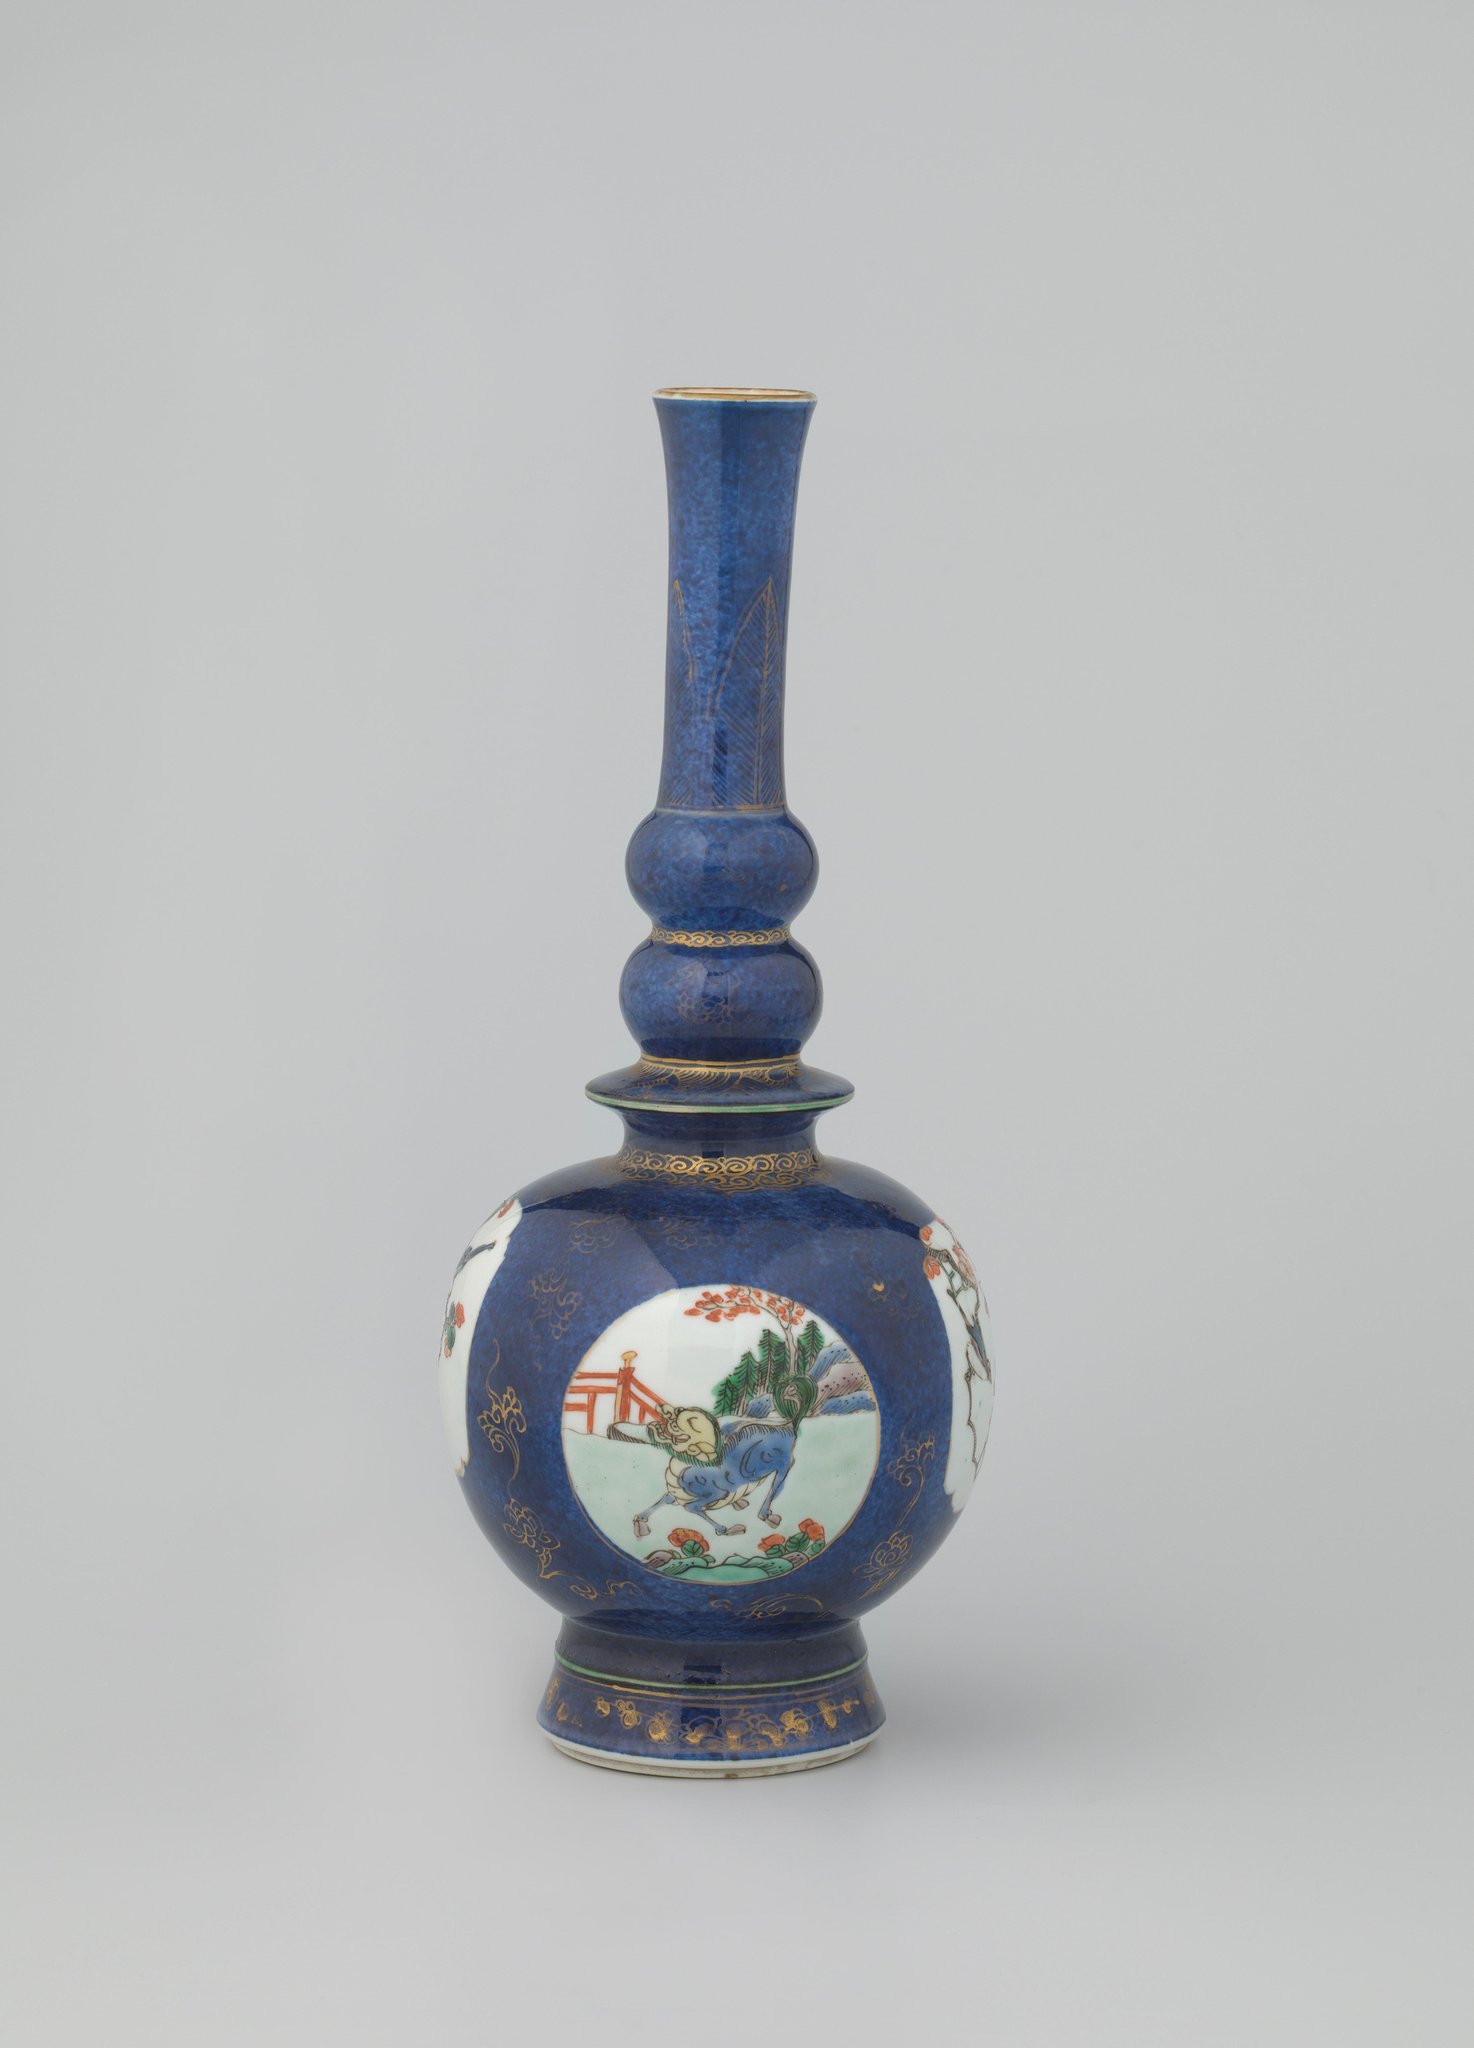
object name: bottle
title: Knobbelfles, bleu poudré met velden in famille verte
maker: Anonymous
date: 1690-1710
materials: cobalt, glaze, porcelain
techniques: gilding, vitrification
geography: china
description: Fles op een hoge, spreidende voet, een bol lichaam en een lange uitlopende hals geleed met twee bollen en een scherp gekante rand vlak boven het lichaam. De fles is met poederblauw bedekt waarop decoratieve banden in goud. Op het lichaam vier maal afwisselend een rond en langwerpig veld met daarin een oranje leeuw die naar links loopt in een landschap, geschilderd in famille verte-kleuren. Bleu poudré met famille verte.